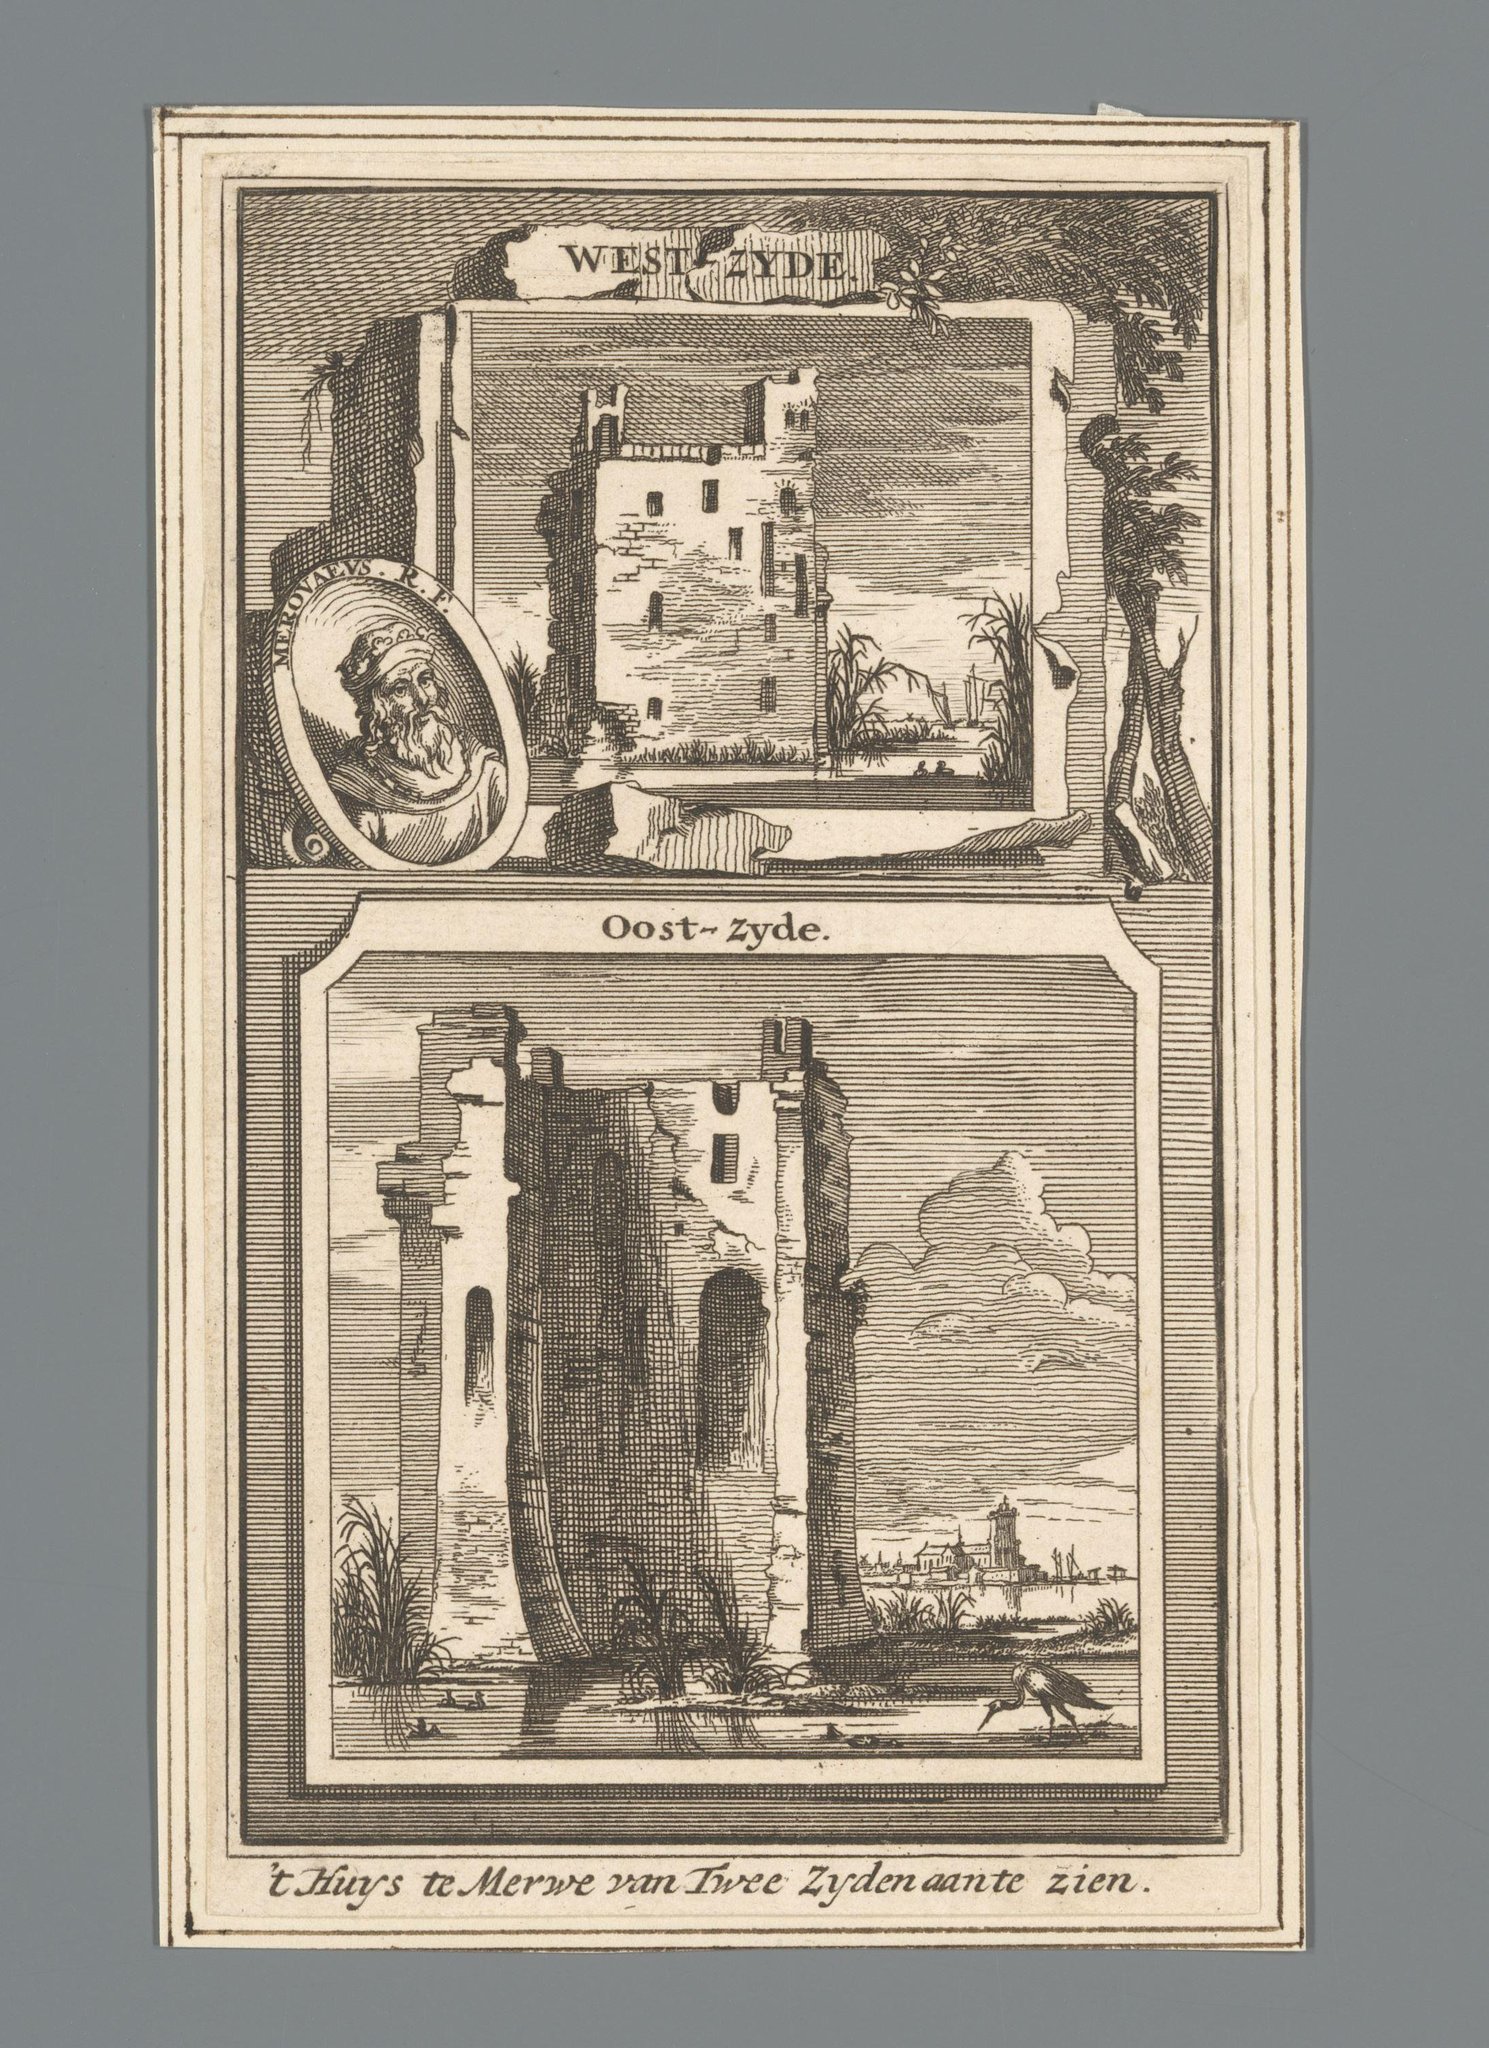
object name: print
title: 't Huys te Merwe van Twee Zyden aan te zien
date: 1701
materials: paper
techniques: etching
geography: amsterdam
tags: ruin of a dwelling, house, castle, etc.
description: Prent uit: Antiquitates Belgicae of Nederlandsche oudtheden (...). Amsterdam: Jacob van Royen, 1701.